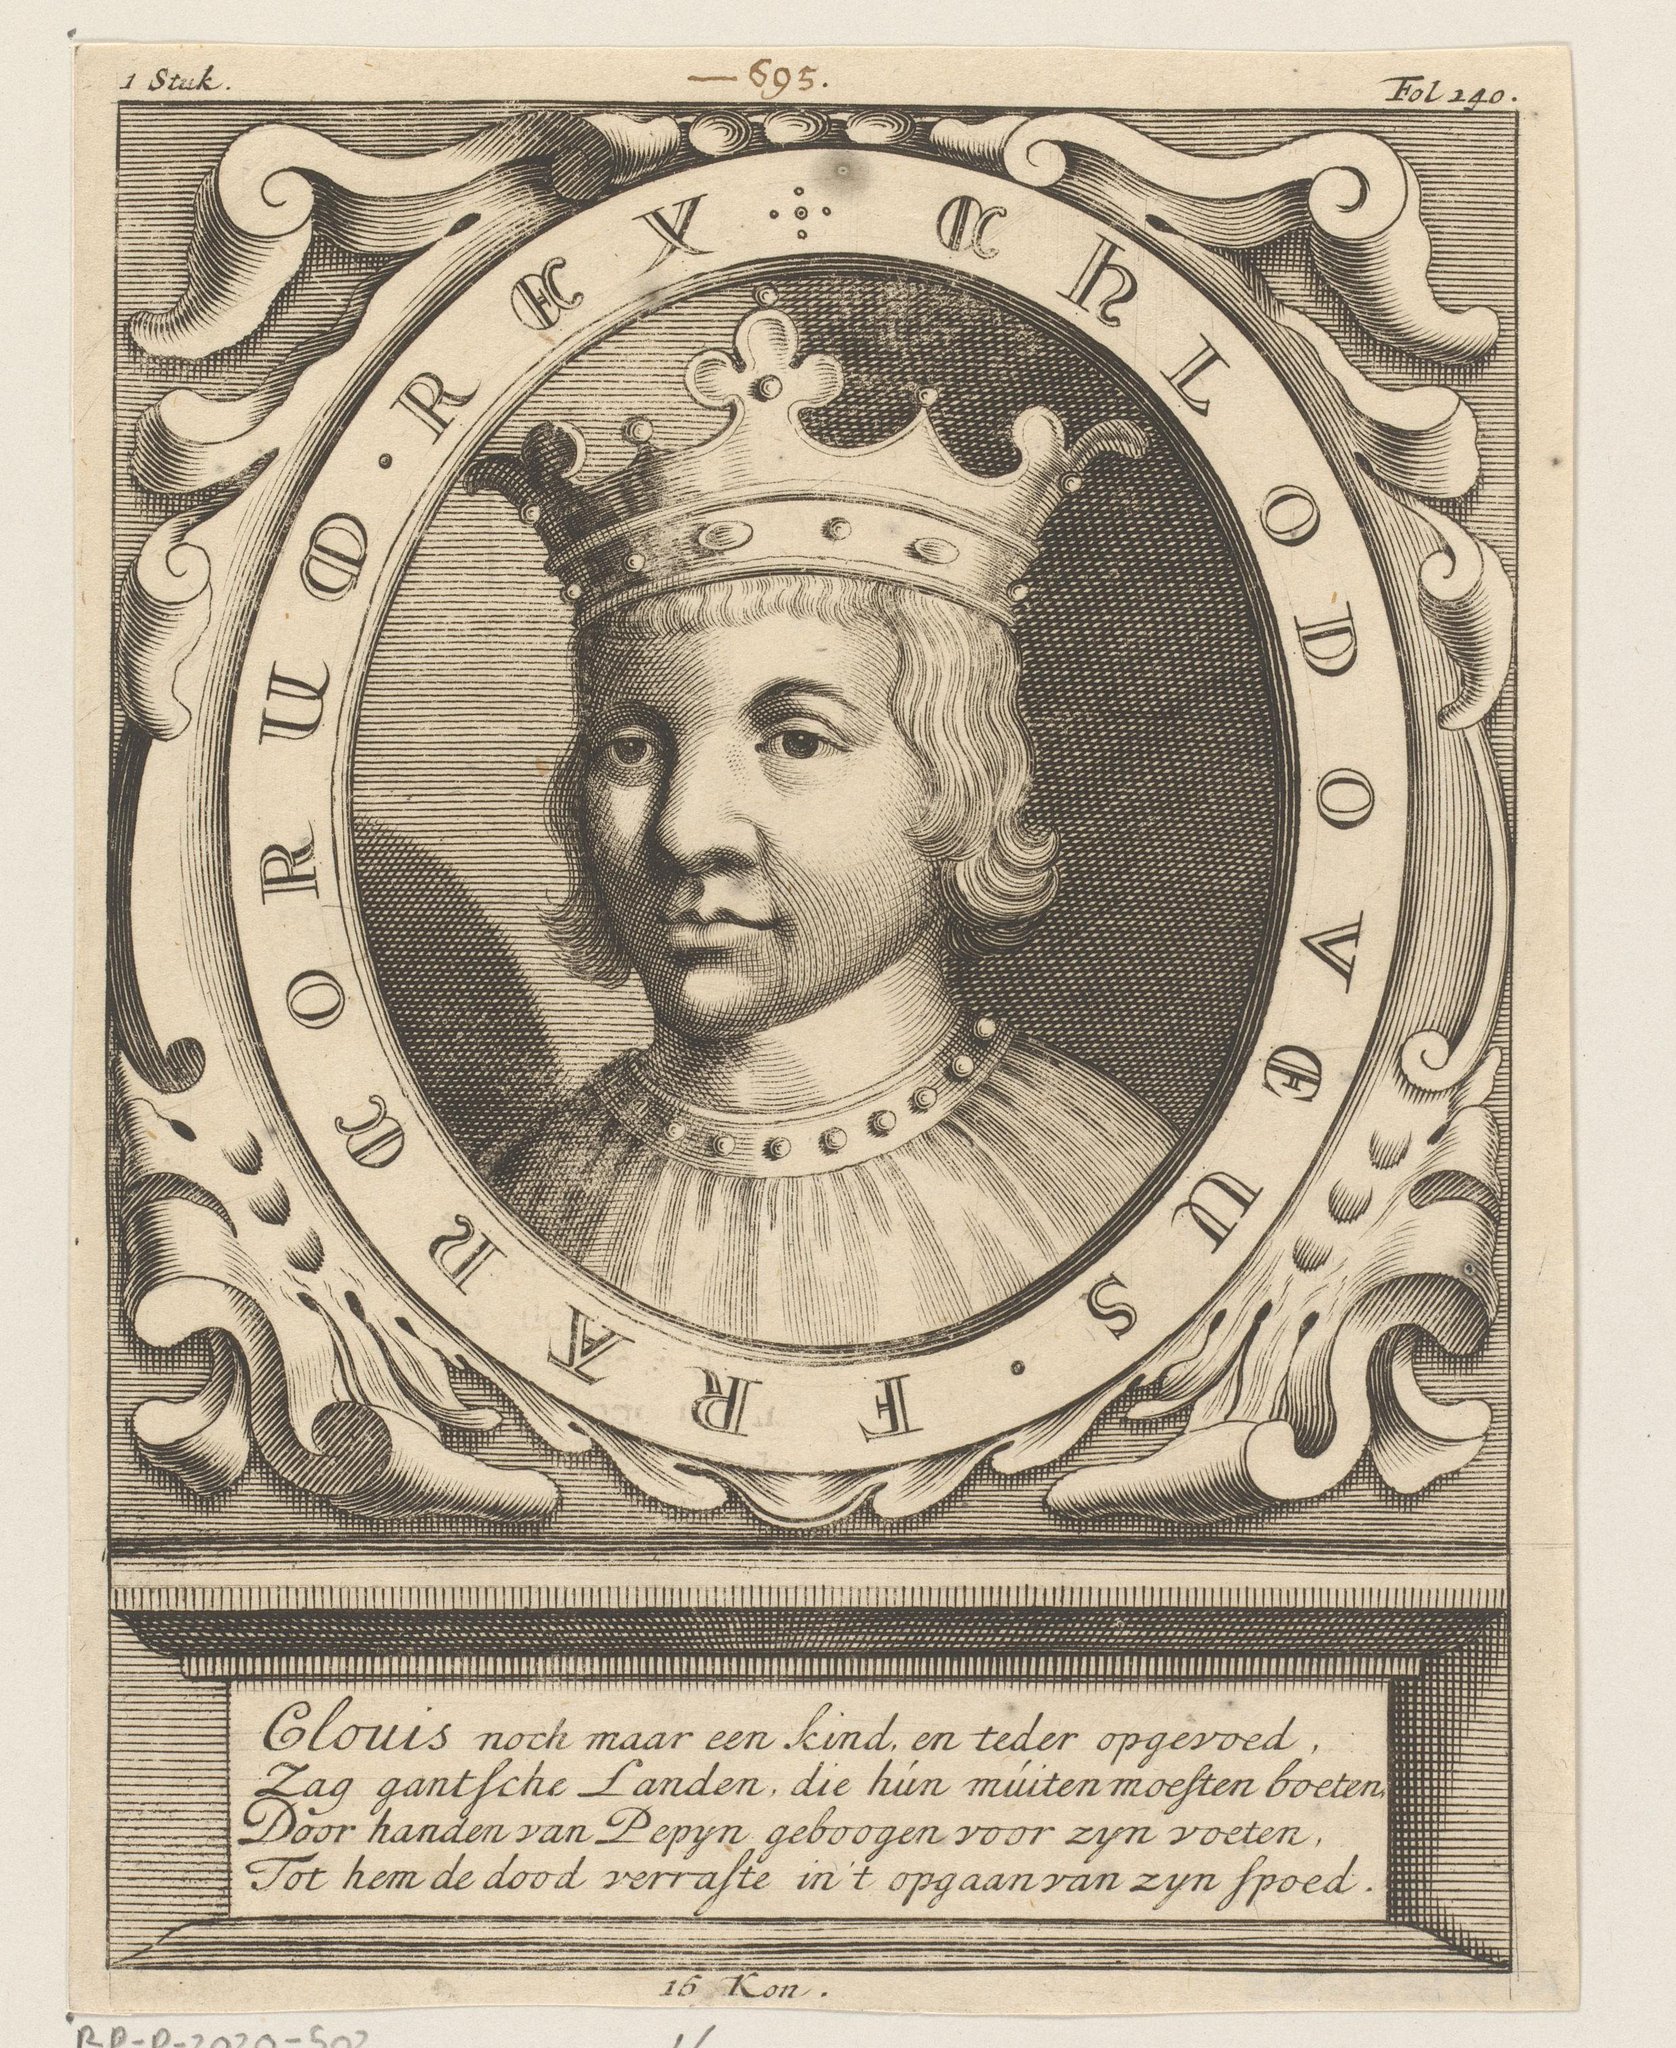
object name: print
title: Portret van Clovis IV, koning van Neustrië, Bourgondië en Austrasië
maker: Anonymous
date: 1685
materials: paper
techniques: engraving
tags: historical persons, king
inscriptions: inscription: ‘-695.’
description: Prent gebruikt in: Eudes de Mézeray, François. Chronyk van Vrankryk. 6 dln. Amsterdam: Jan Bouman en Timotheum ten Hoorn, 1685, dl. 1.